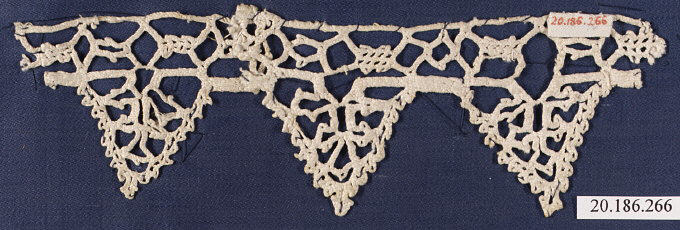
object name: edging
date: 1501-1700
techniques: lace